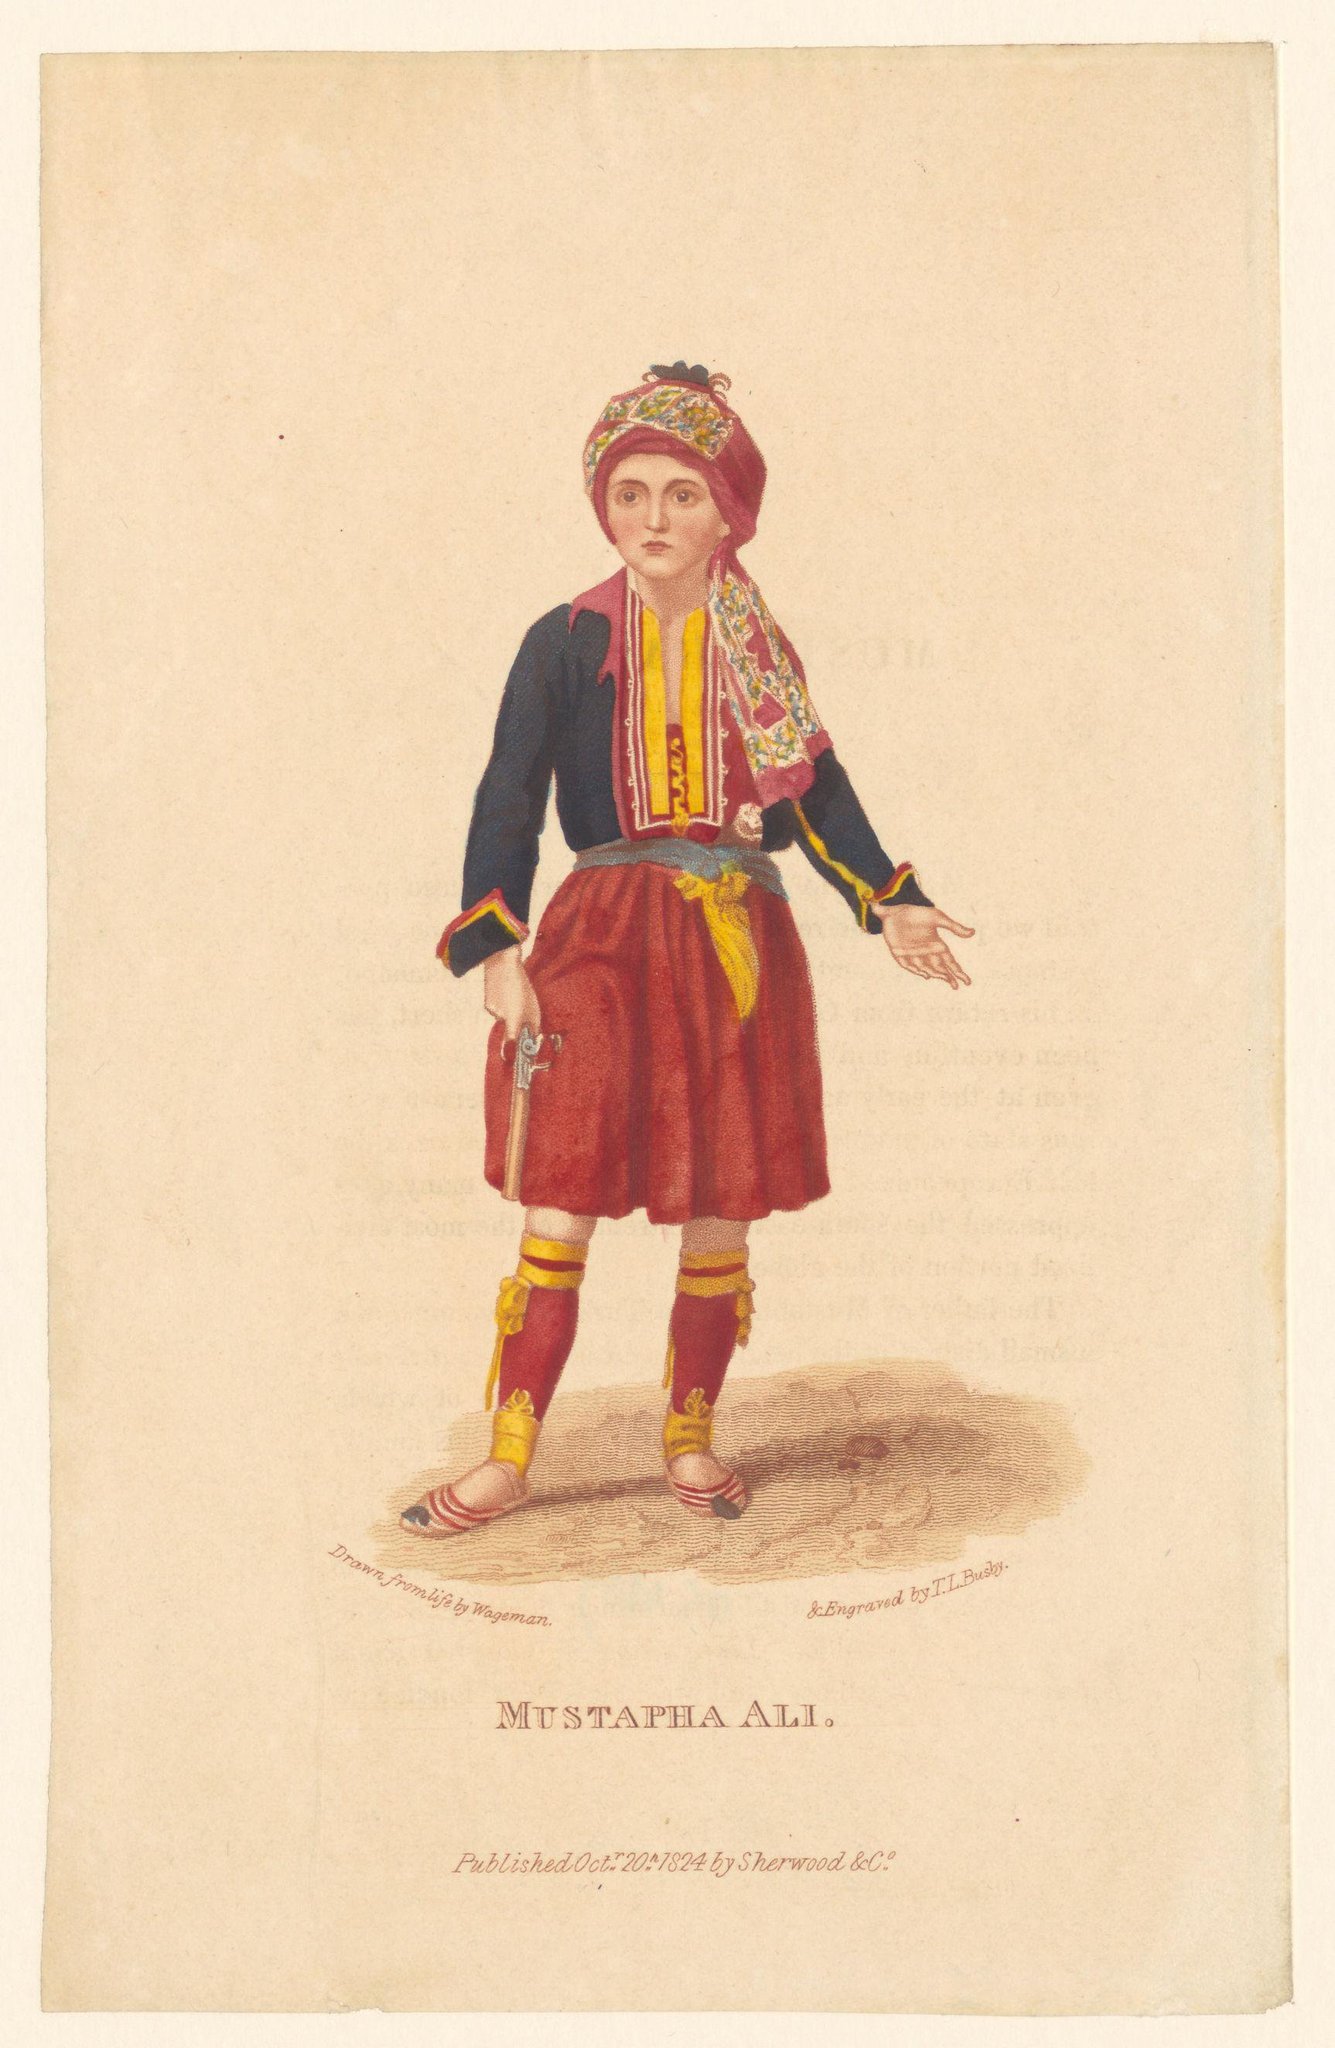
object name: book illustration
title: Mustapha Ali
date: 1810-1824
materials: paper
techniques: etching, hand coloring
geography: london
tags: boy (child between toddler and youth), historical persons, head-gear: turban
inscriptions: collector's mark: Lugt 2228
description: Prent uit: Stanhope, Leicester. Greece in 1823 and 1824 (...). Londen: Sherwood, Jones and co., 1824.